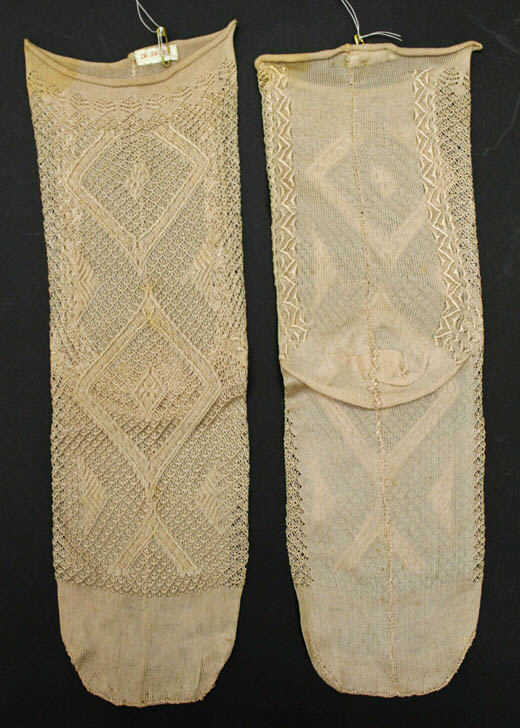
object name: sock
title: Socks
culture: italian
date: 1801-1833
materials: silk